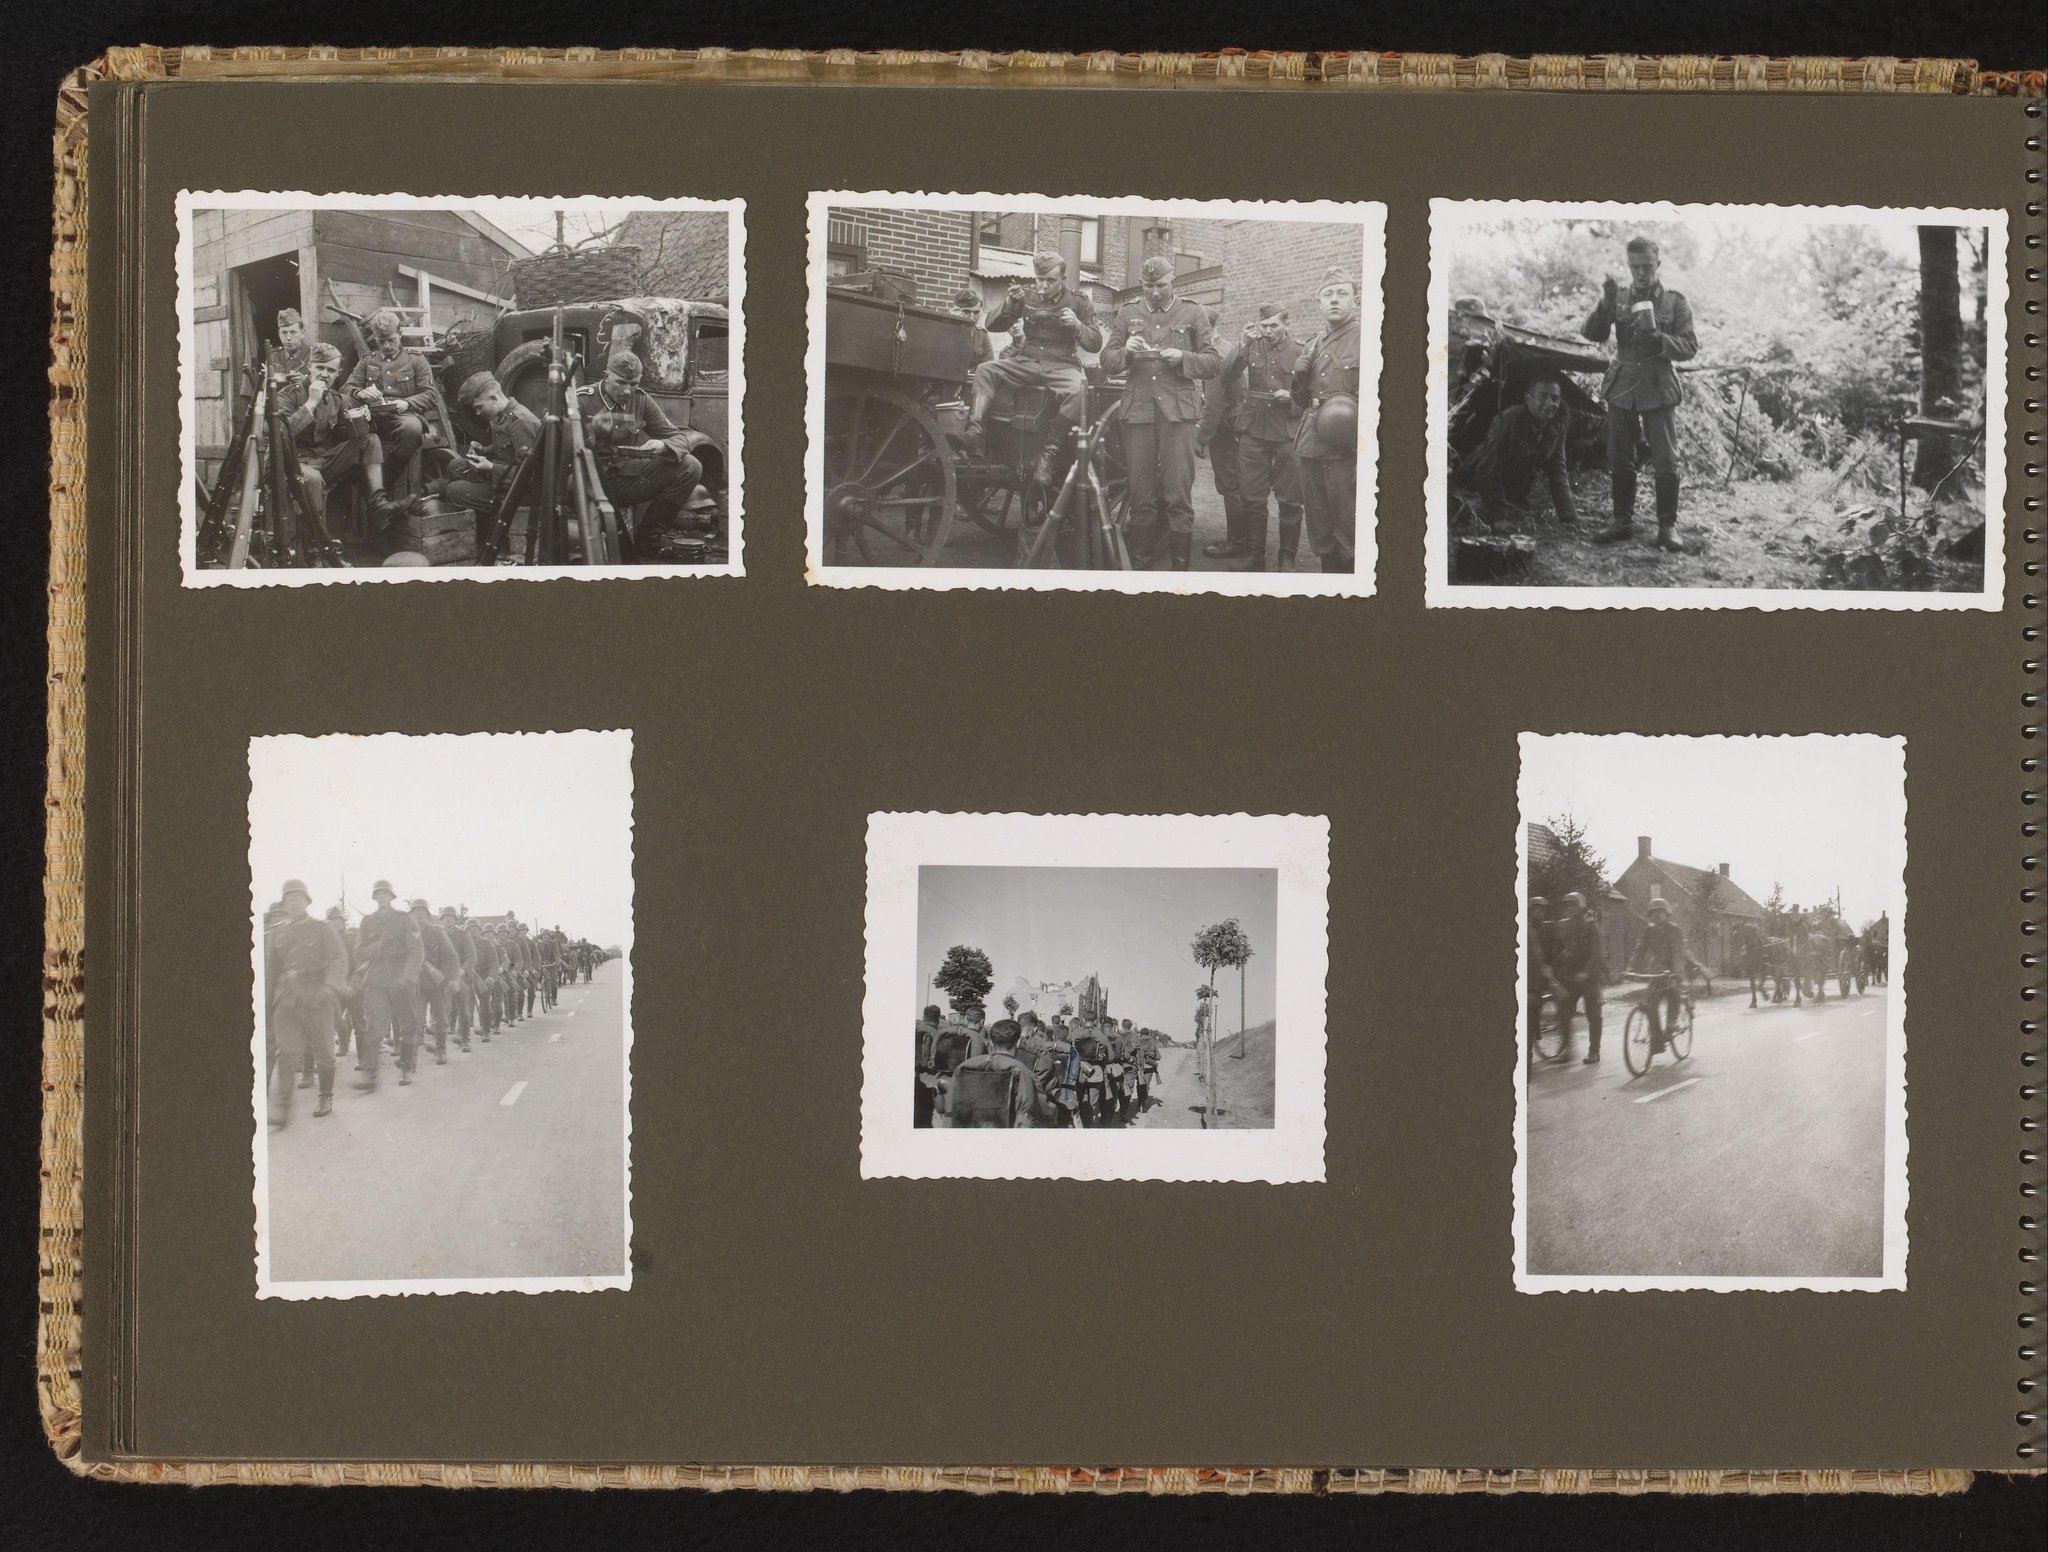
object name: album leaf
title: Eten en marcheren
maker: Anonymous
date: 1940-1943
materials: cardboard, photographic support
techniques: gelatin silver print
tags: army 'en route', serving of food ~ military service, the soldier off duty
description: Albumblad met zes foto's van Duitse militairen aan het eten en onderweg in kolonne. Onderdeel van het fotoalbum Duitse bezetting van Nederland.